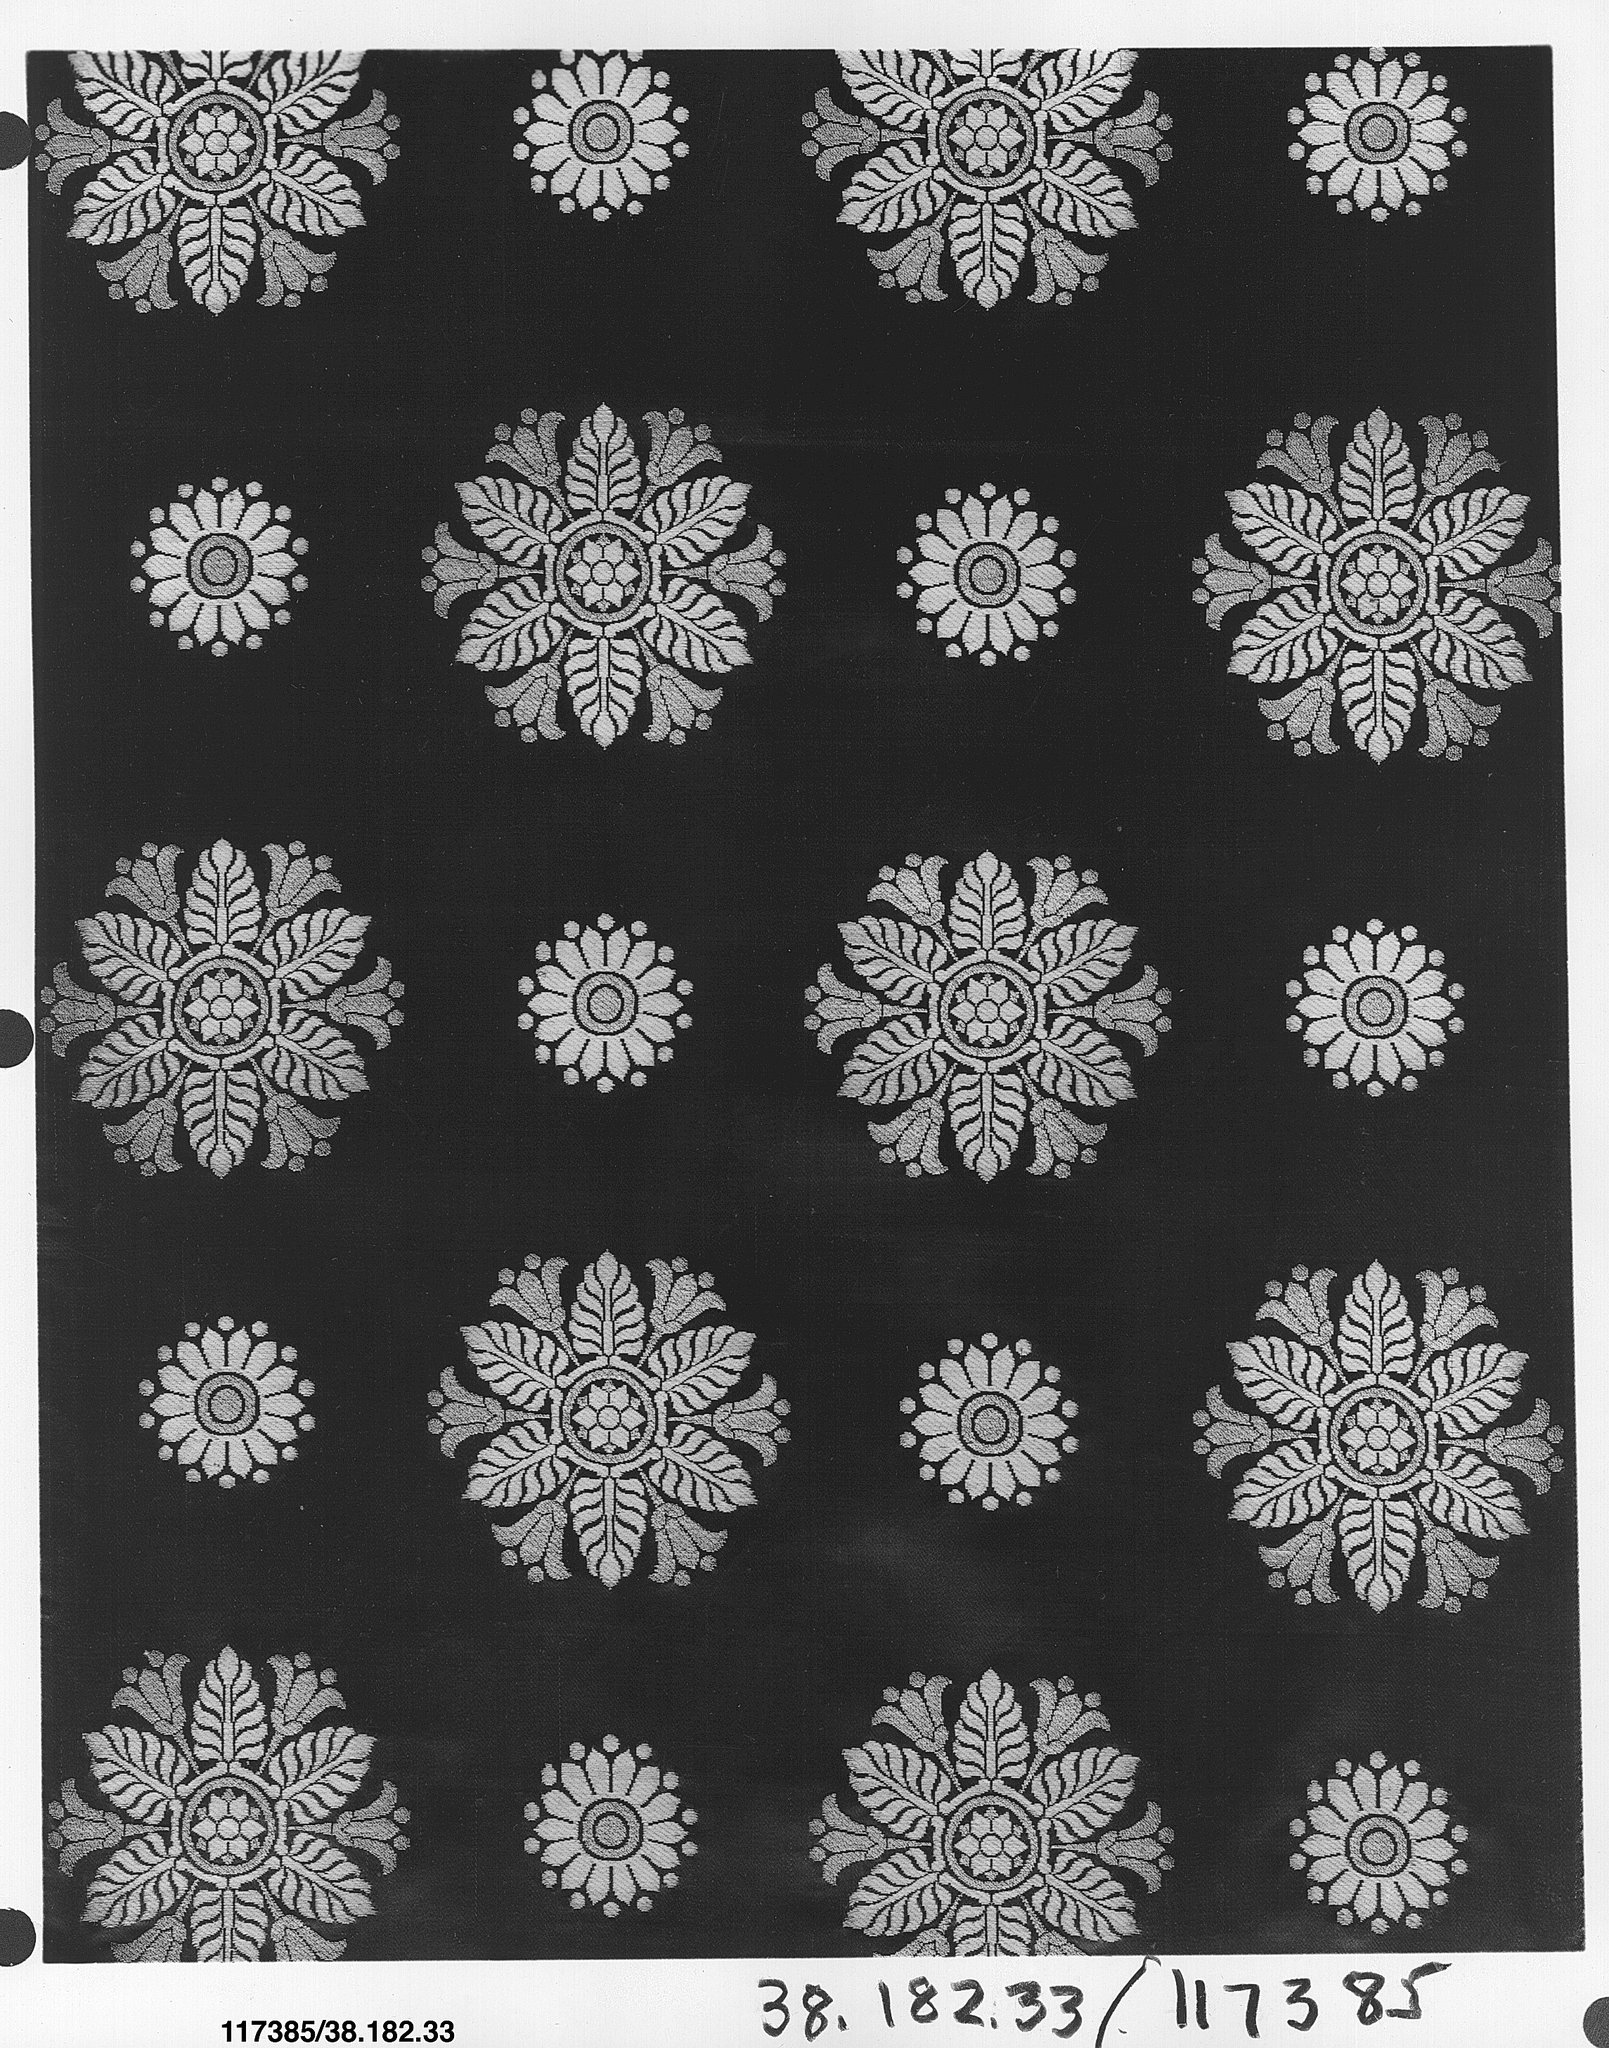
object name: piece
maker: séguin et cie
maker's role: manufactory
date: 1805-1815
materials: metal thread, silk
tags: flowers